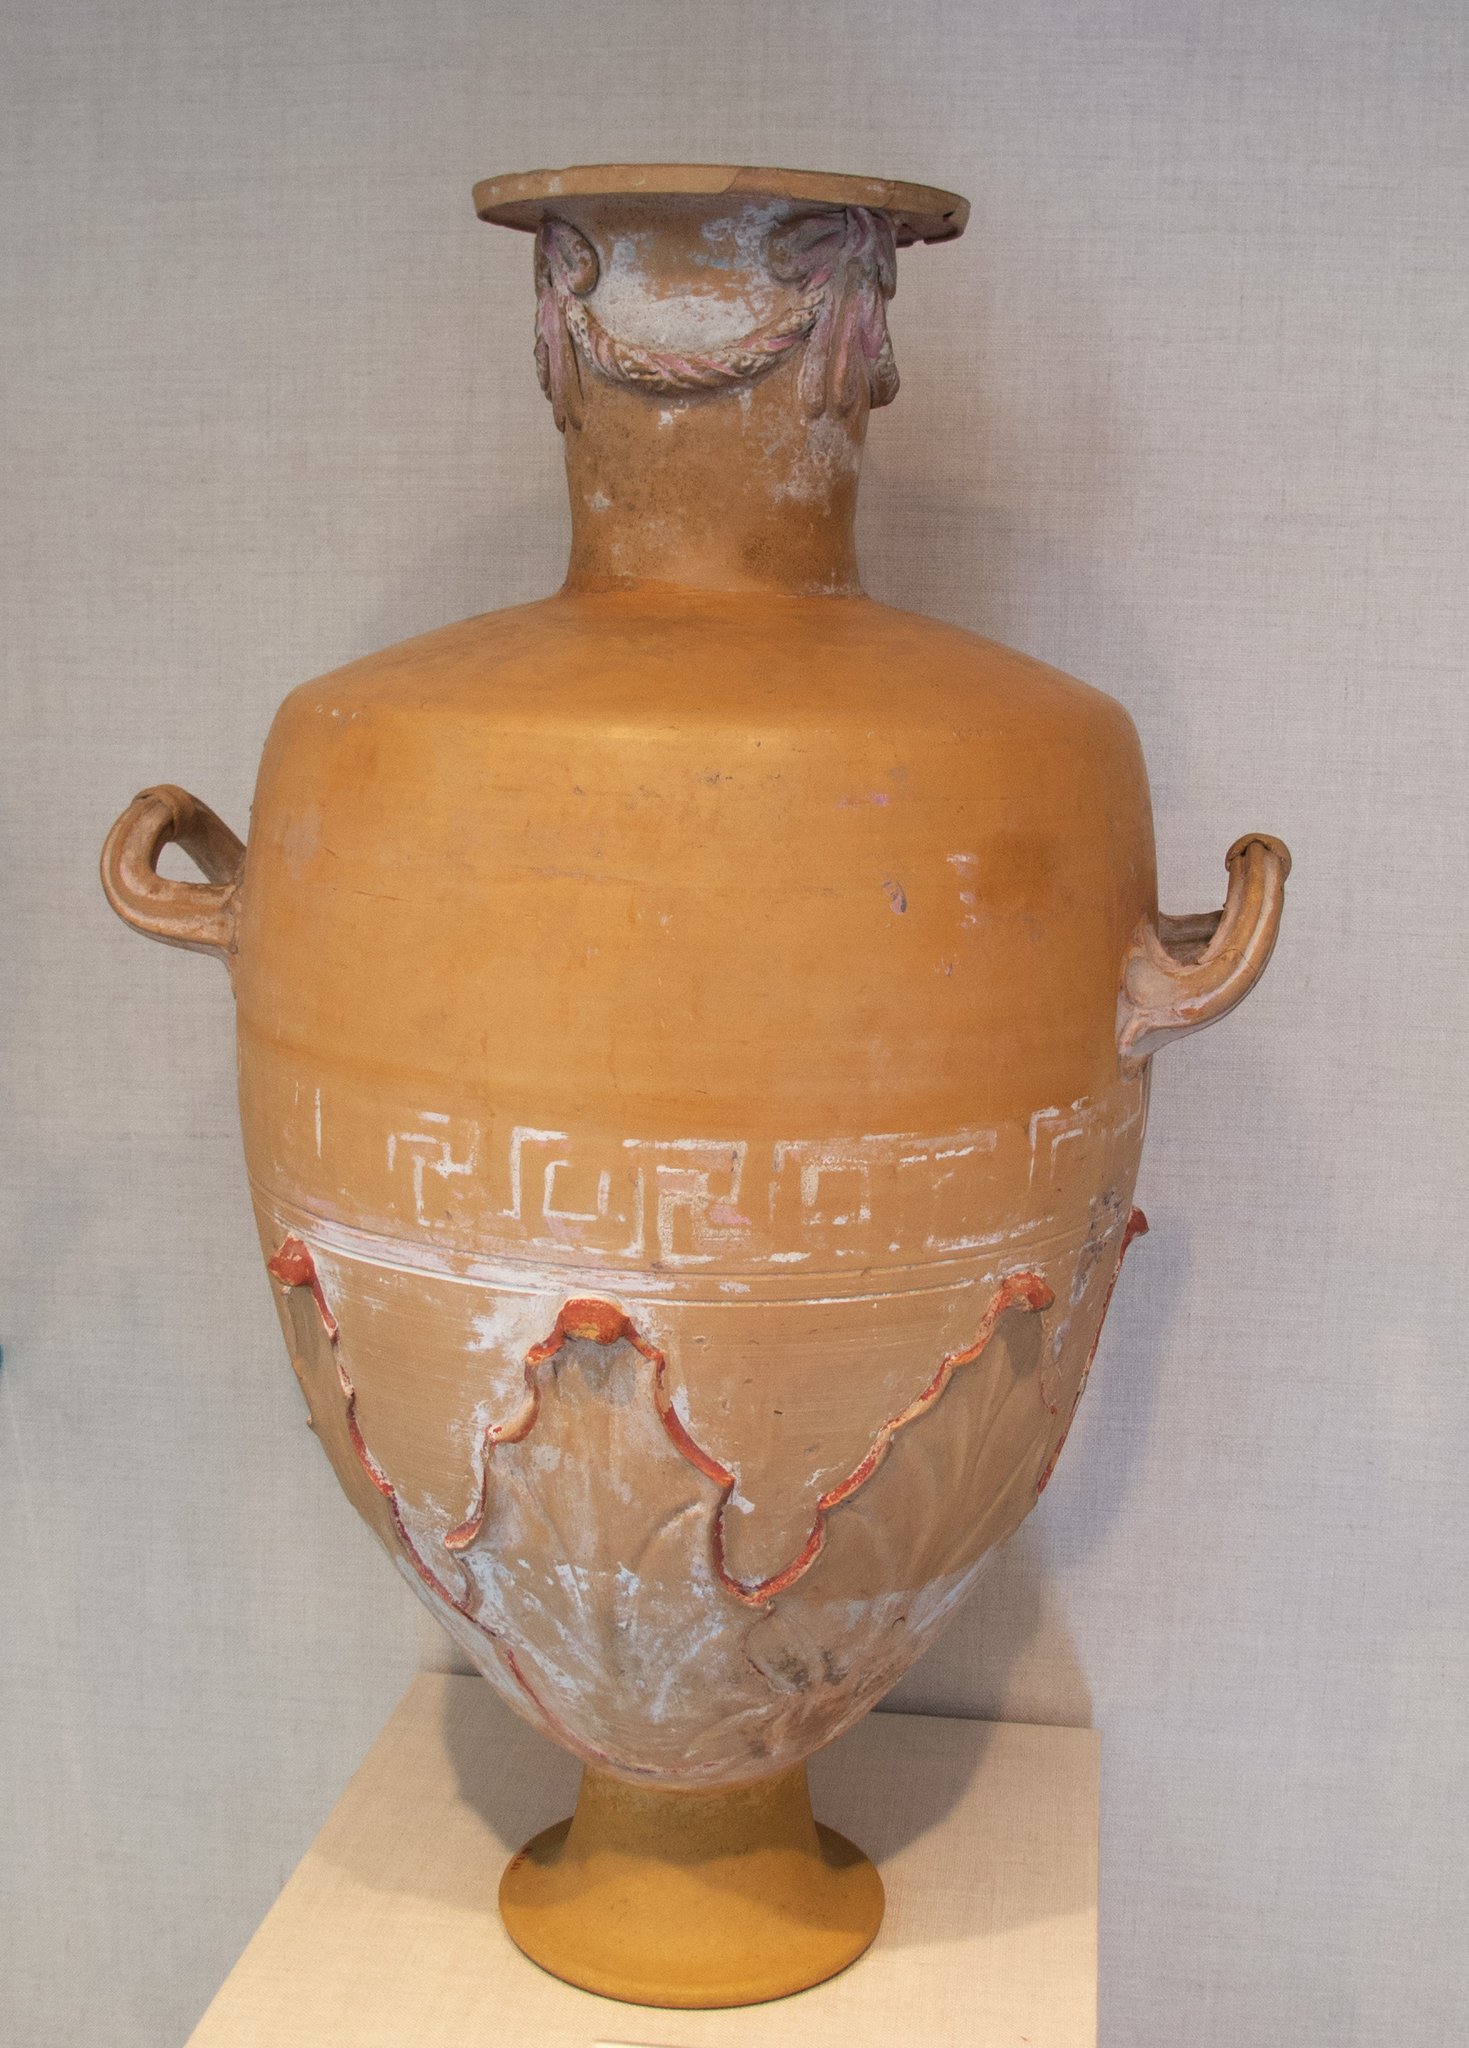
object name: hydria, hadra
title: Terracotta Hadra hydria (water jar)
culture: greek, cretan or ptolemaic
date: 234-201 BCE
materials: terracotta